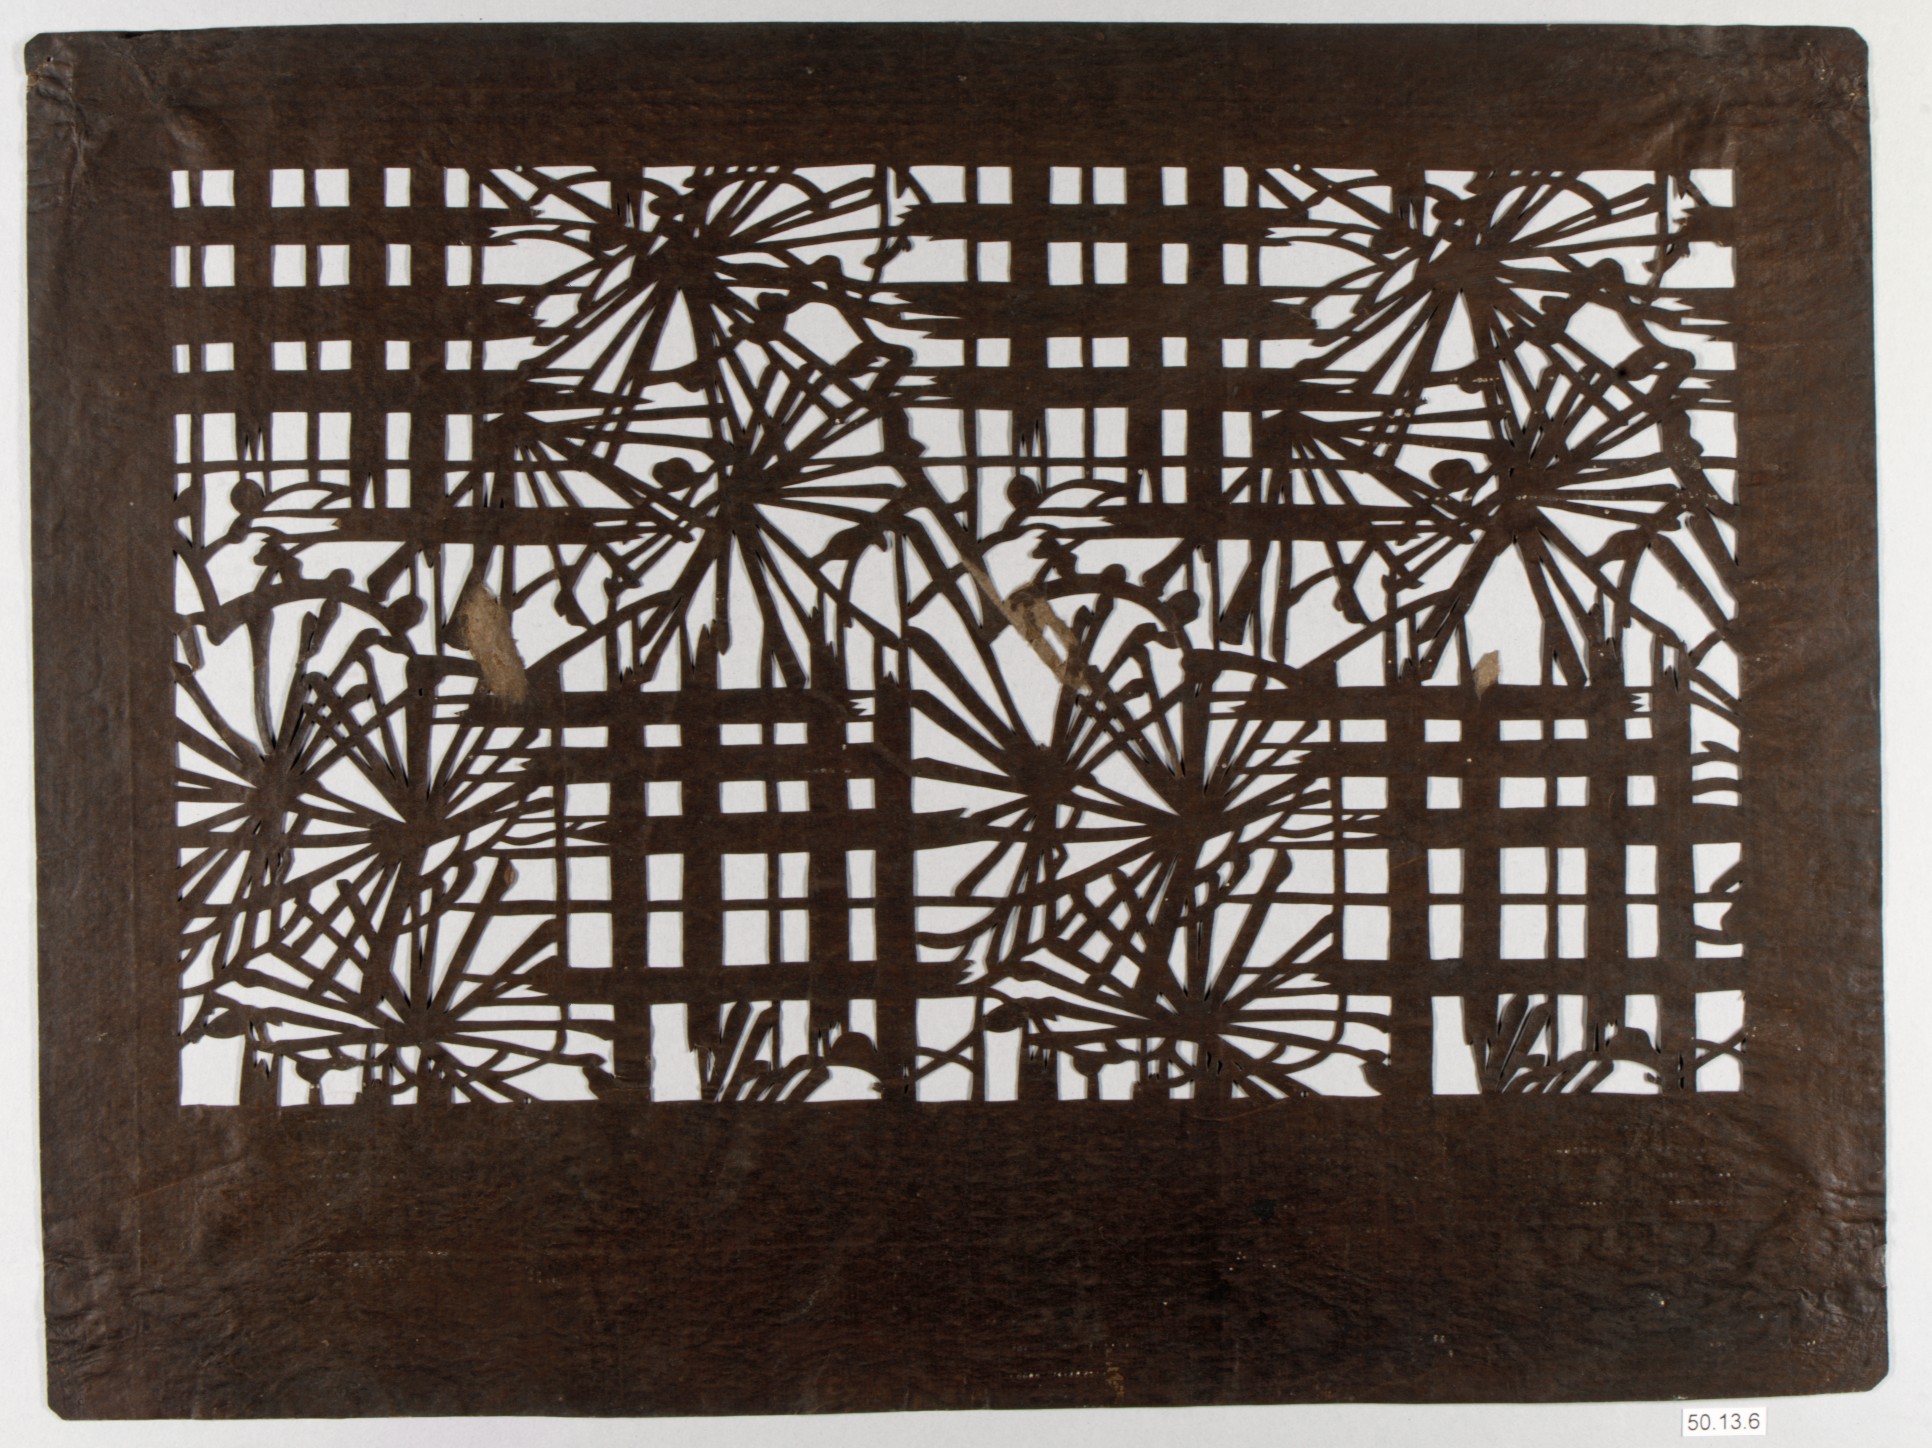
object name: stencil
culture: japanese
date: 1801-1900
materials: paper